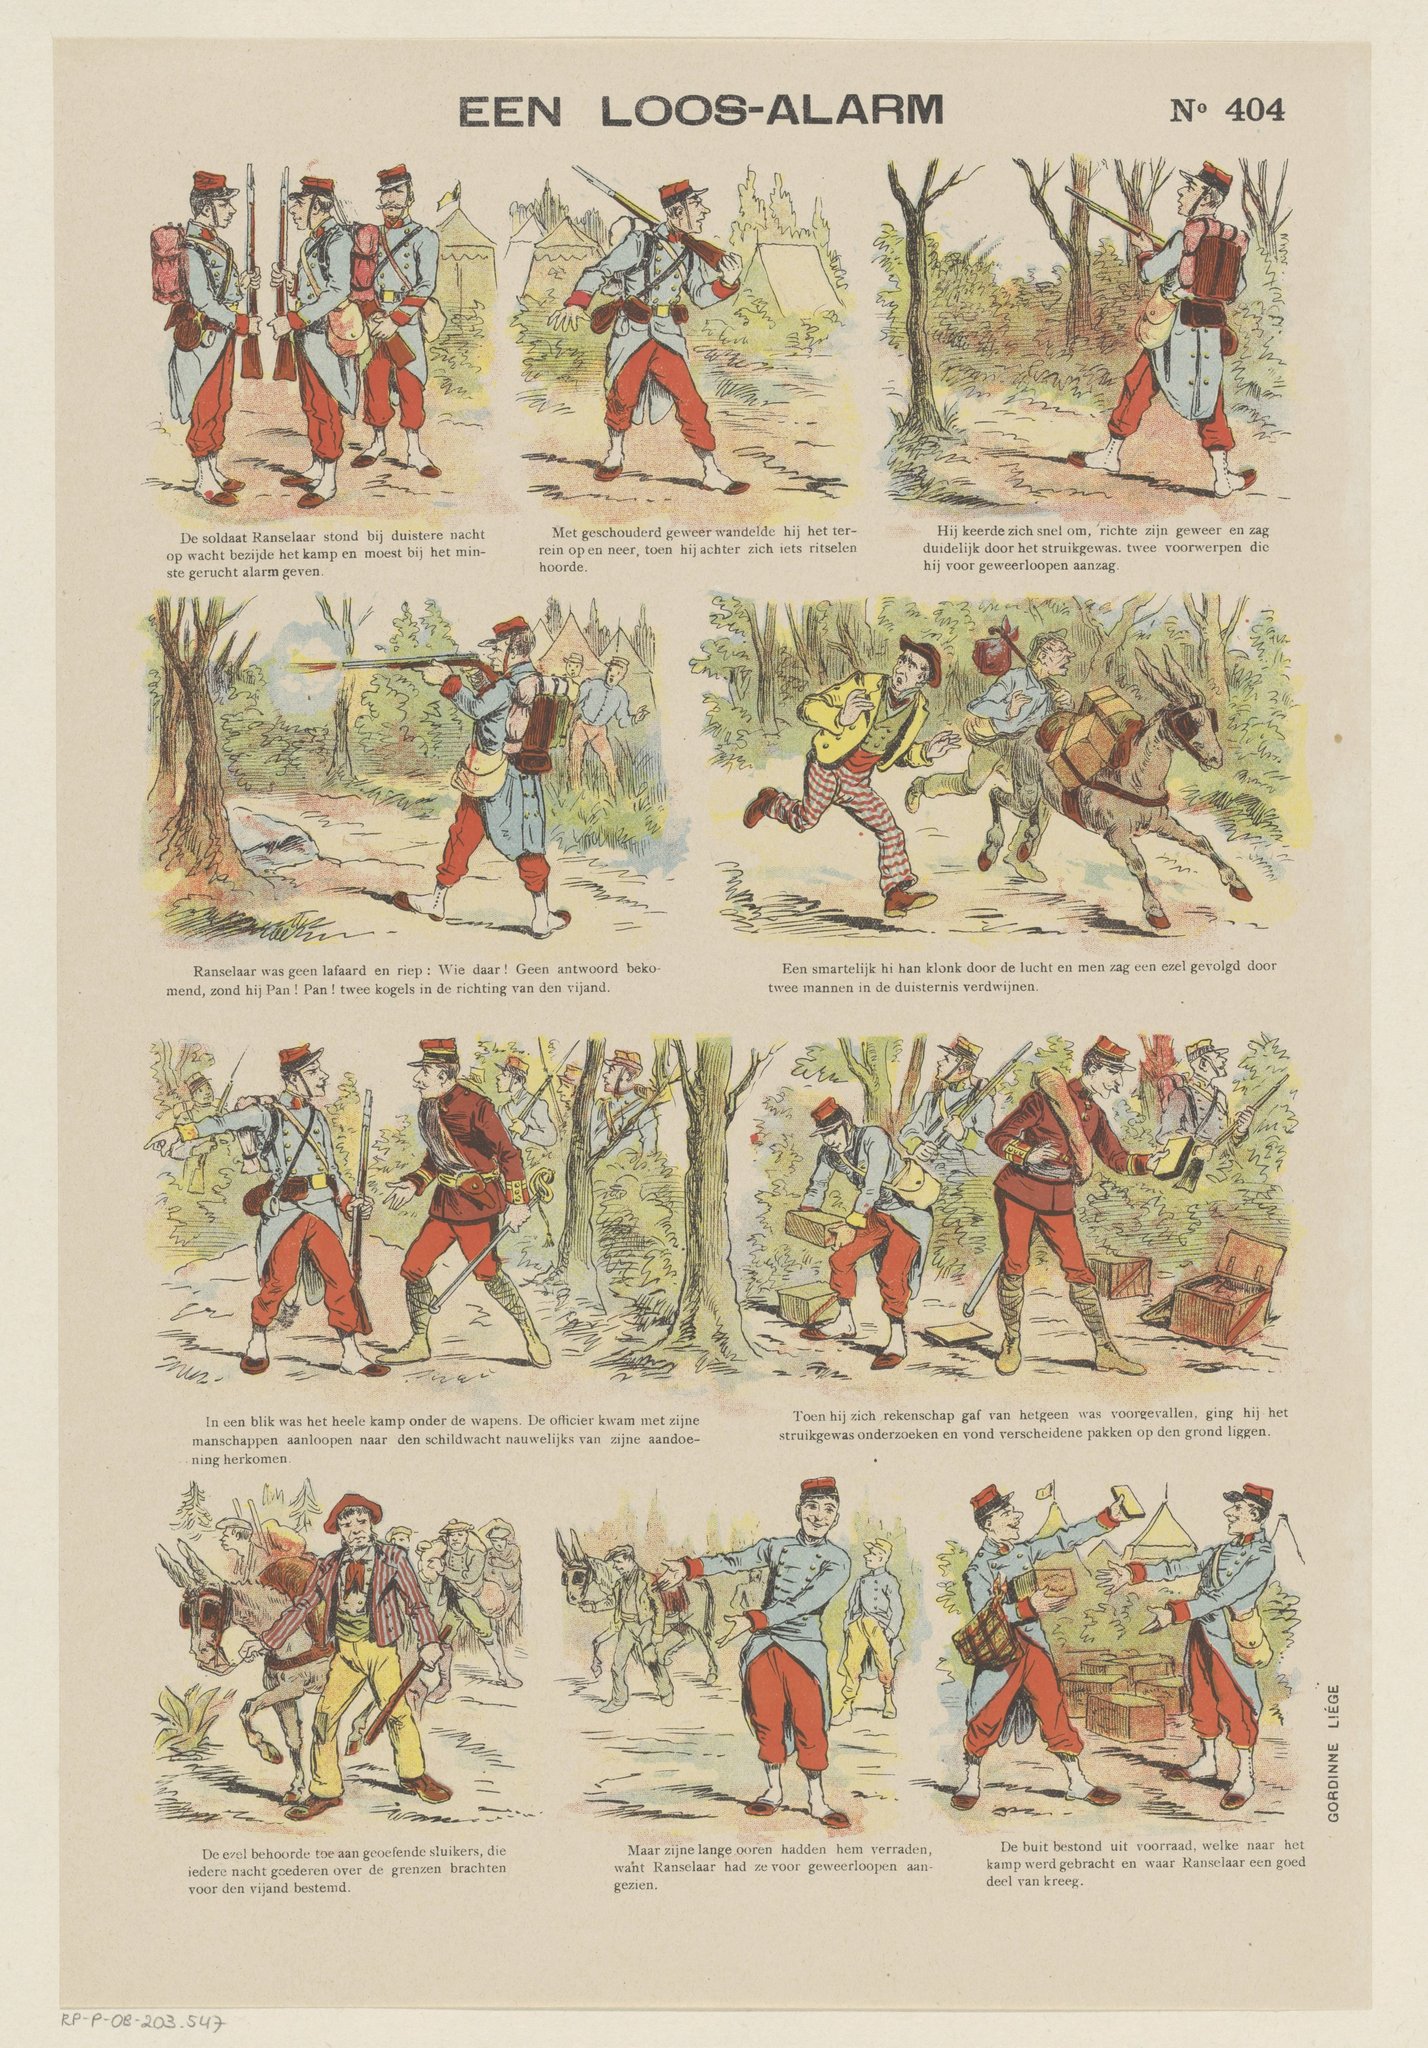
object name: popular print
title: Een loos-alarm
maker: Anonymous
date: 1894-1959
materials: paper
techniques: lithograph, letterpress printing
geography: liège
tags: the soldier; the soldier's life, smuggler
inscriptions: collector's mark: Lugt 2760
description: Blad met 10 voorstellingen over soldaat Ranselaar die twee smokkelaars oppakt. Onder elke afbeelding een onderschrift. Genummerd rechtsboven: No 403.